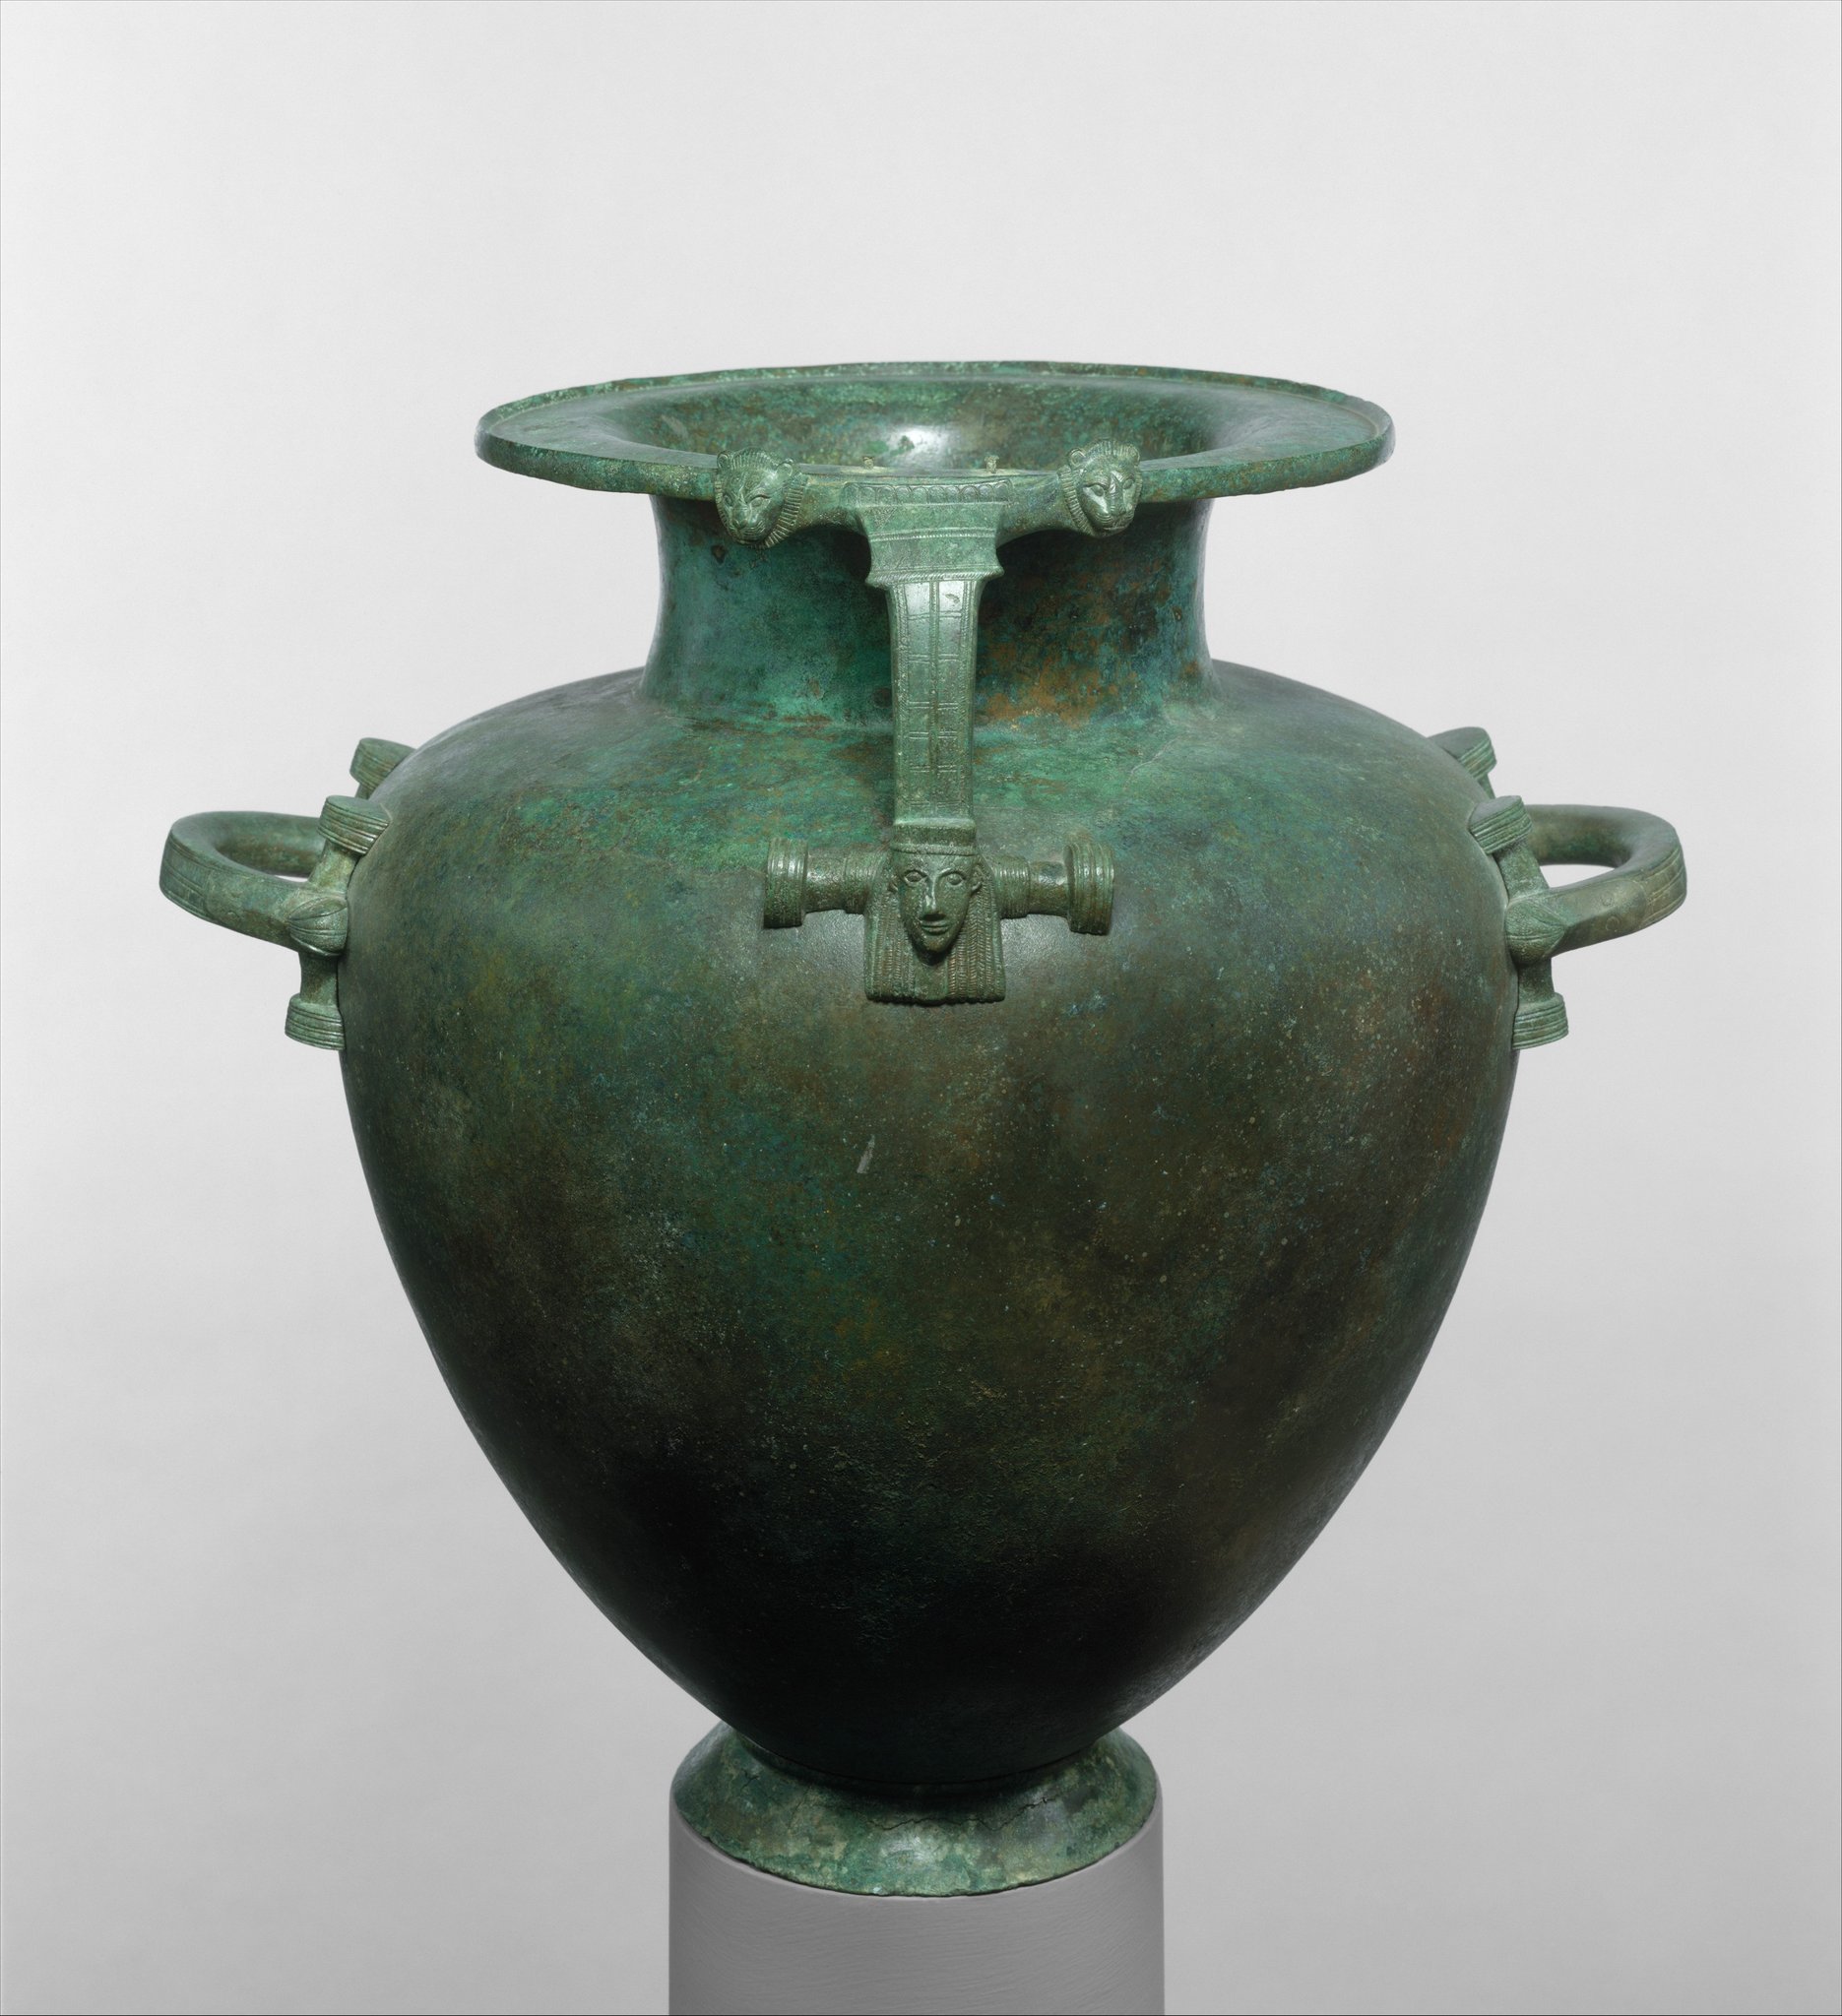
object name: hydria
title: Bronze hydria (water jar)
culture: greek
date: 634-568 BCE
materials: bronze